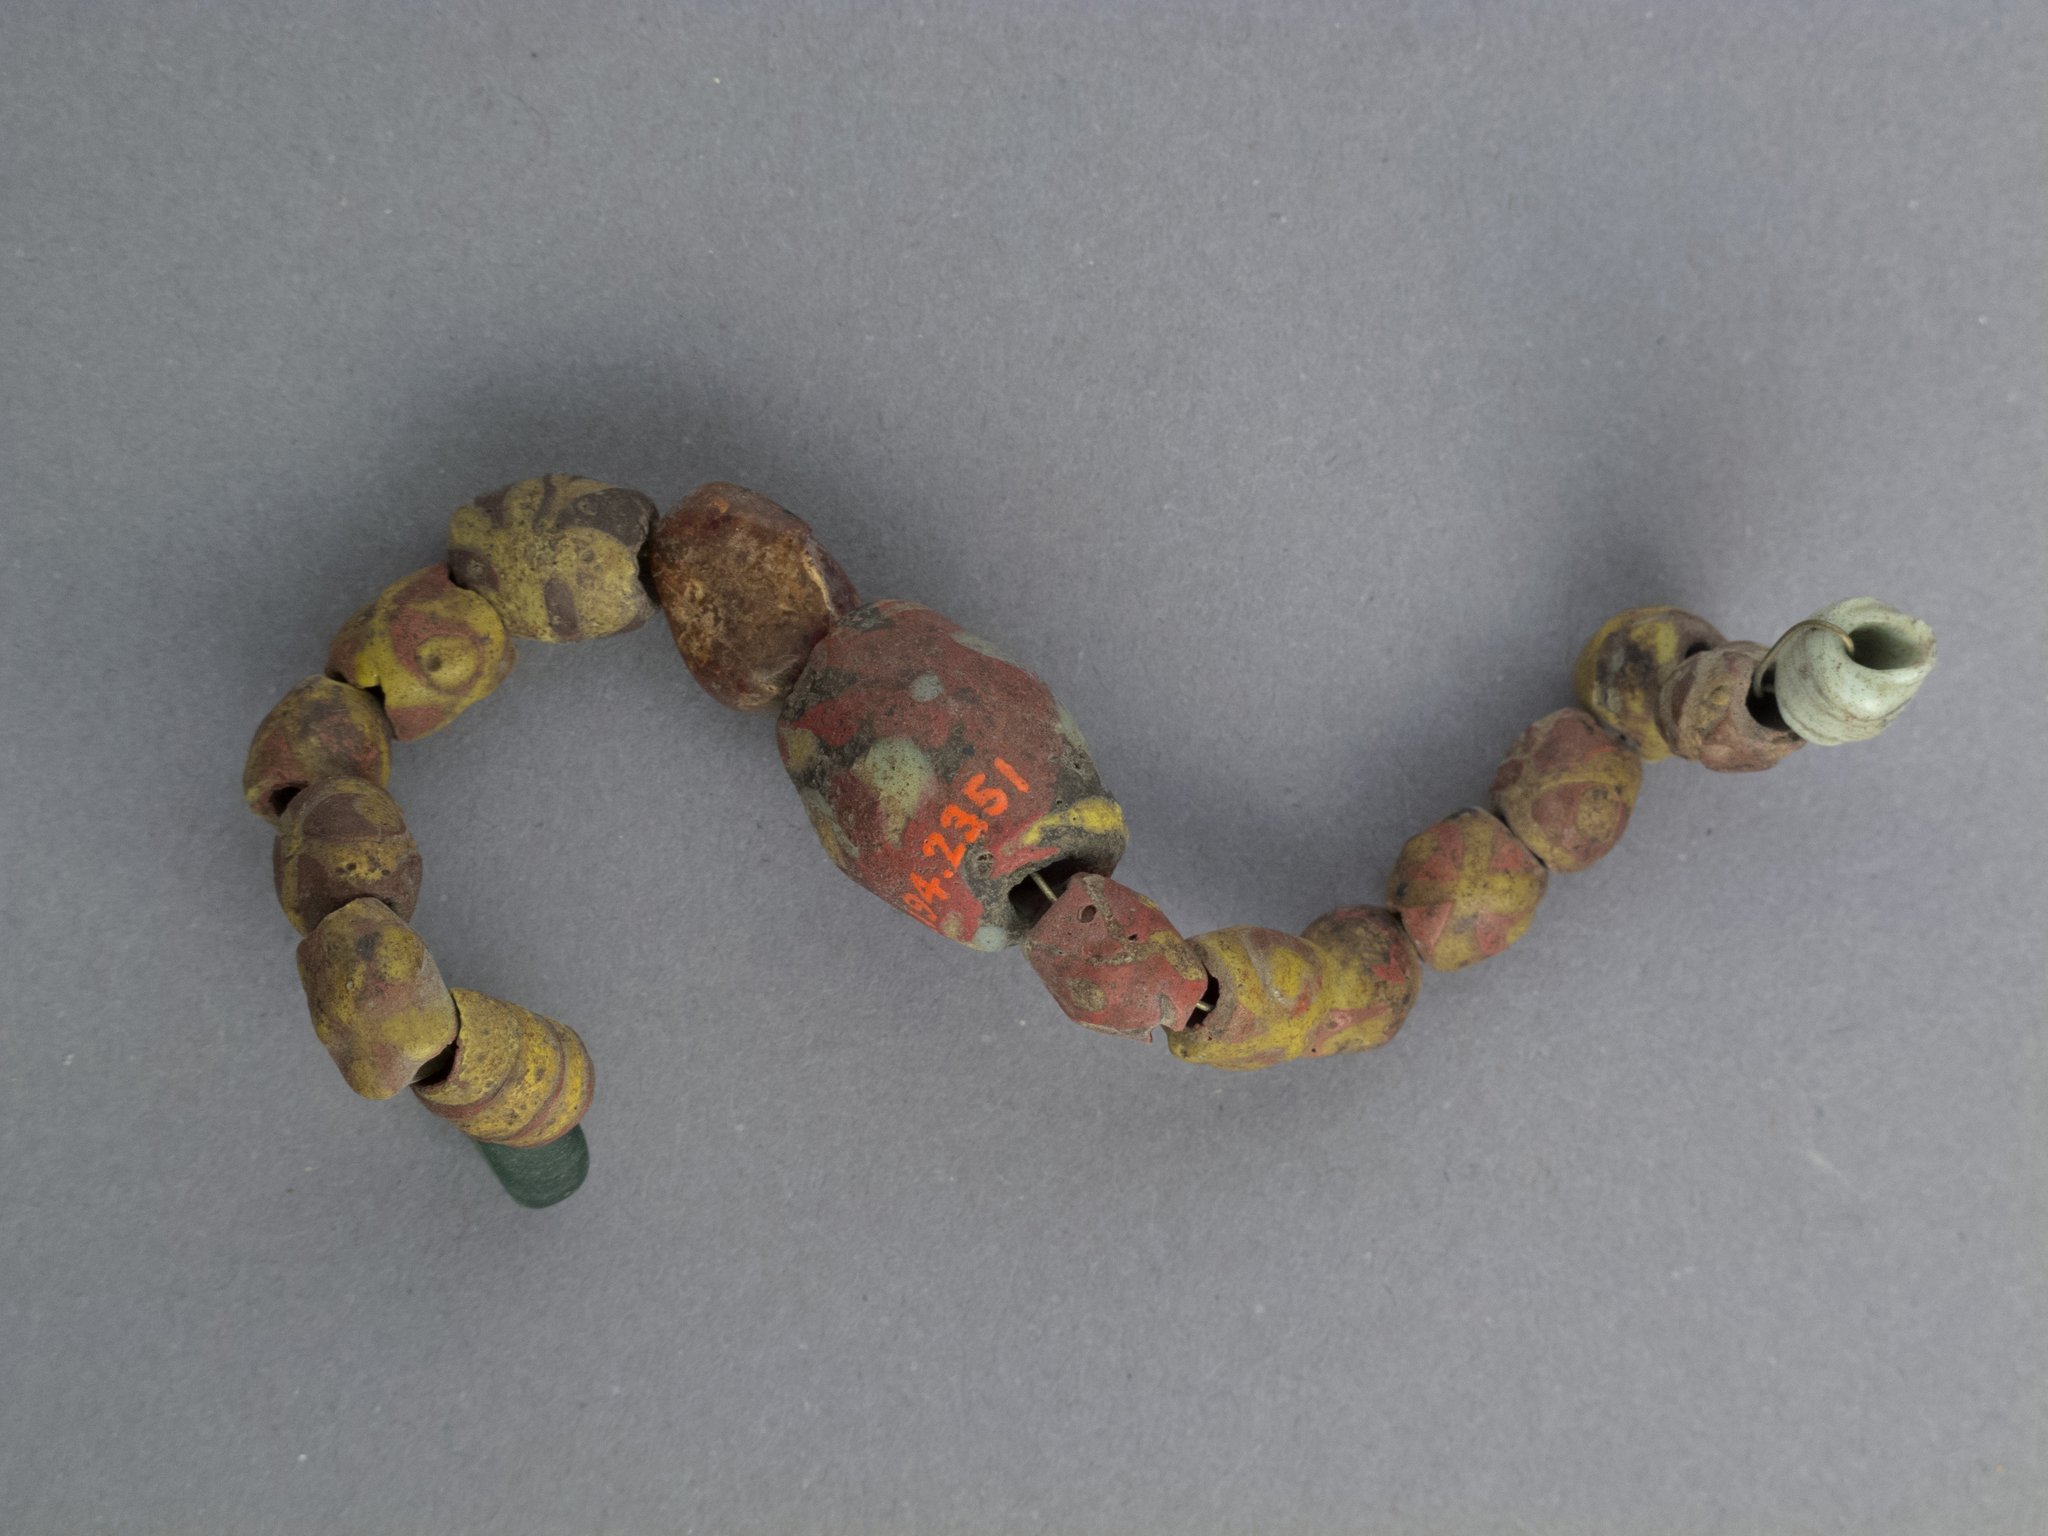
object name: bead, 17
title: Beads, 17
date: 7000 BCE-330 CE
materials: glass